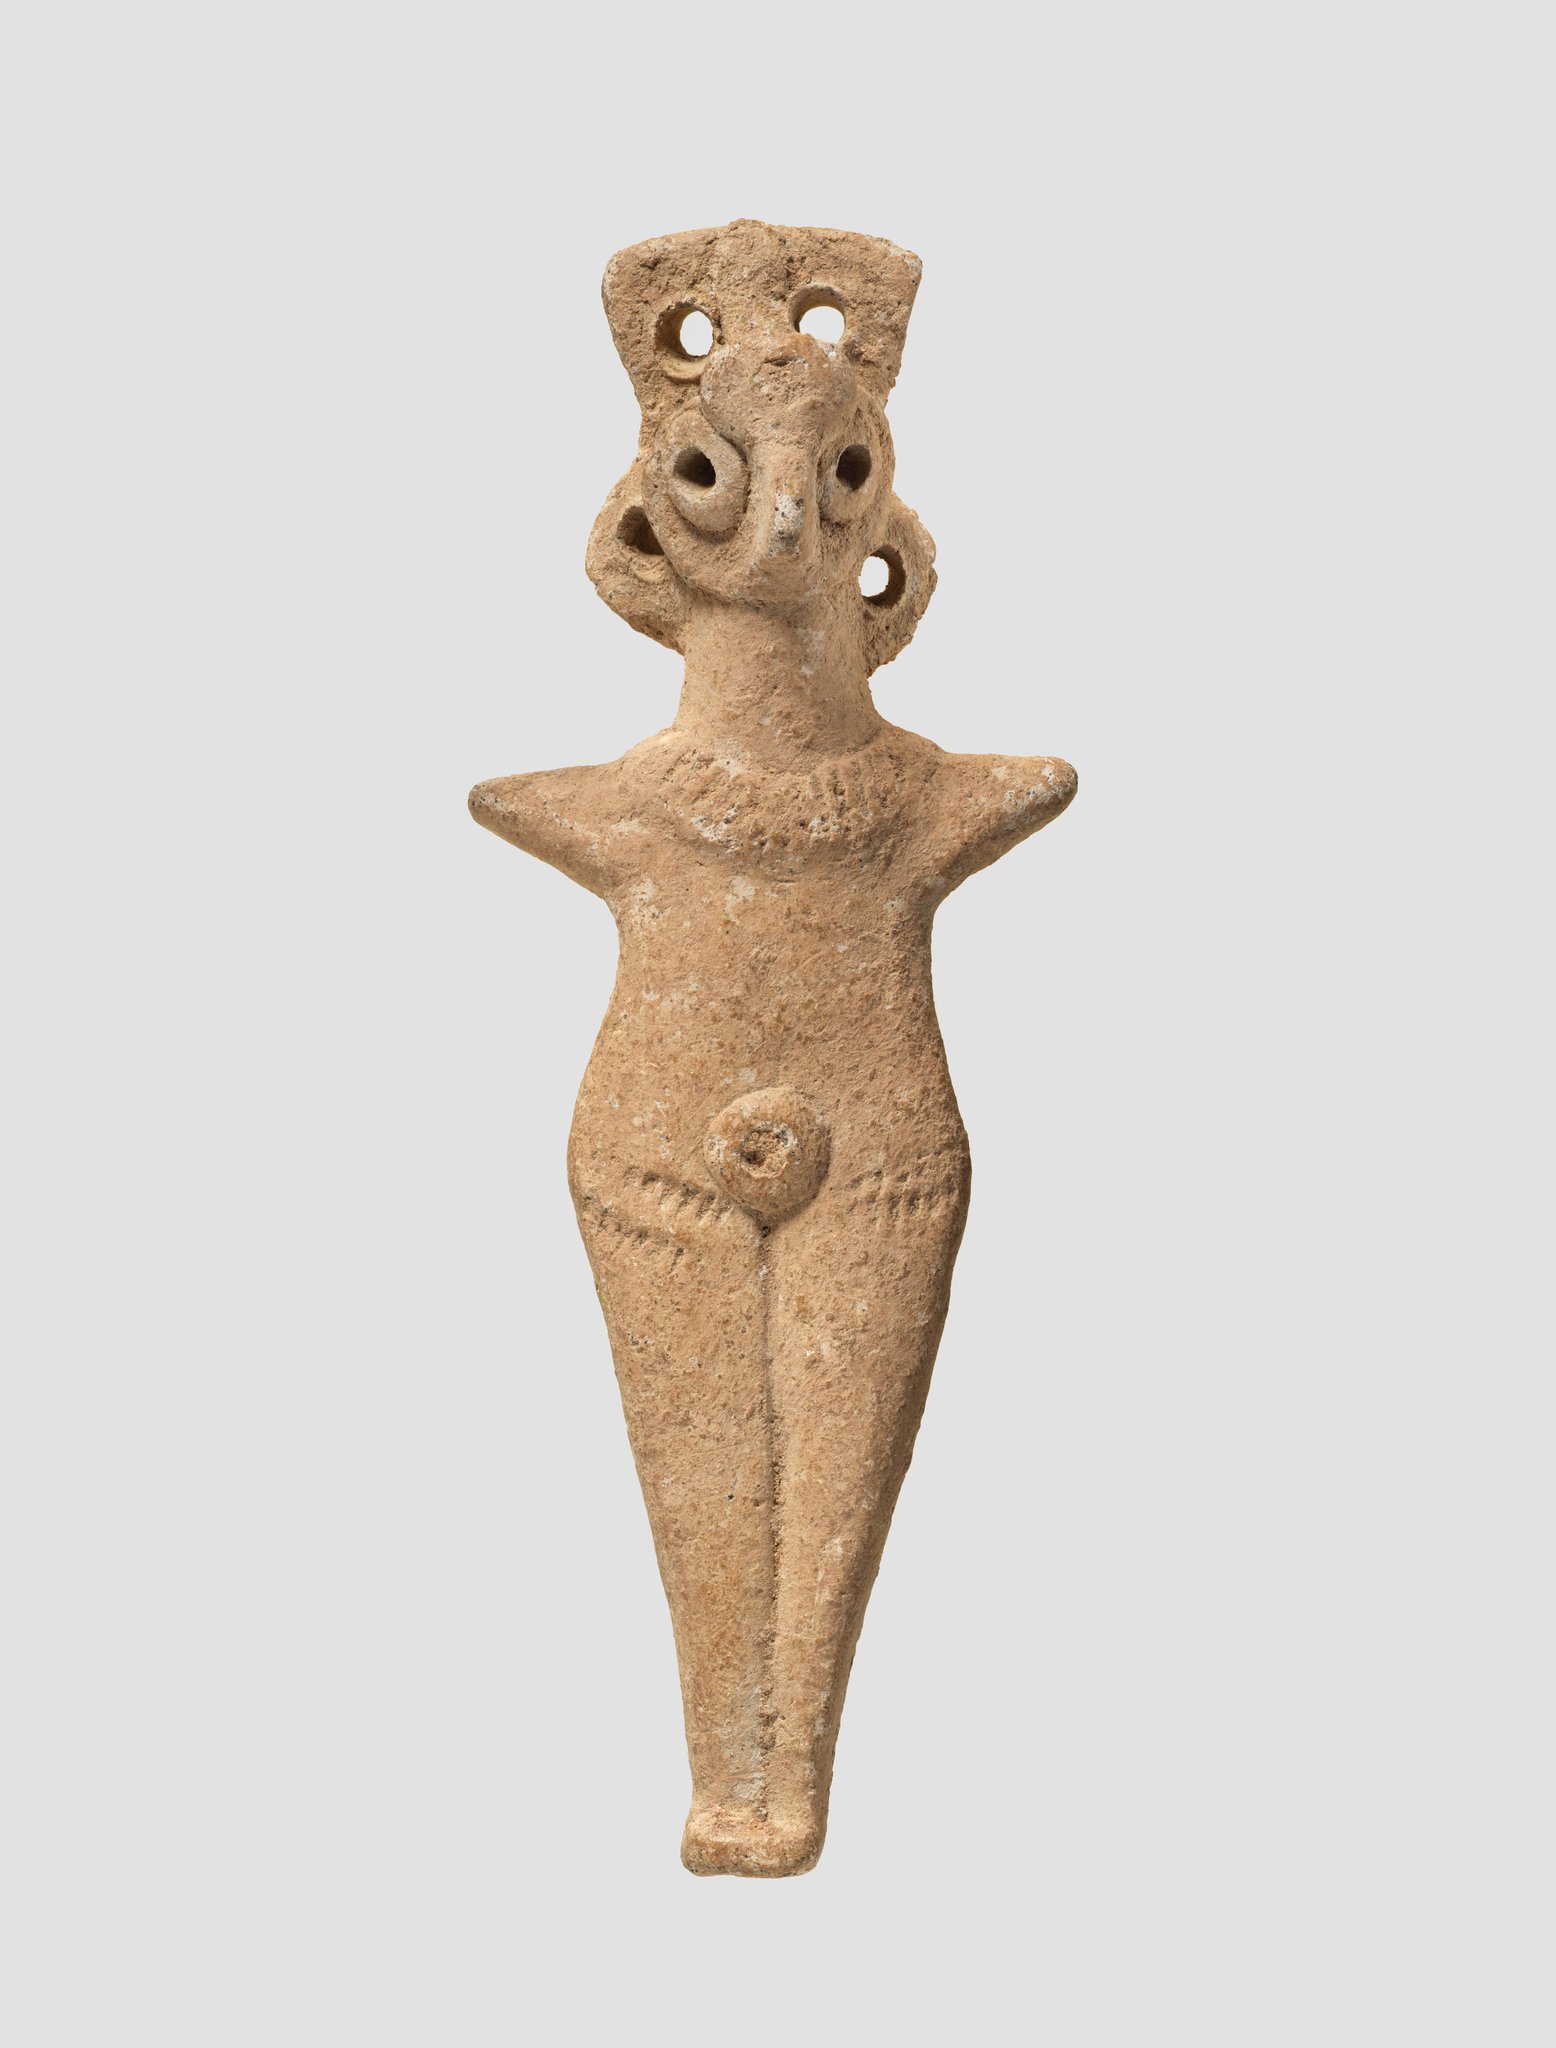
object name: sculpture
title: Nude female figure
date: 2000-1668 BCE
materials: ceramic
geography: levant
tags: female nudes